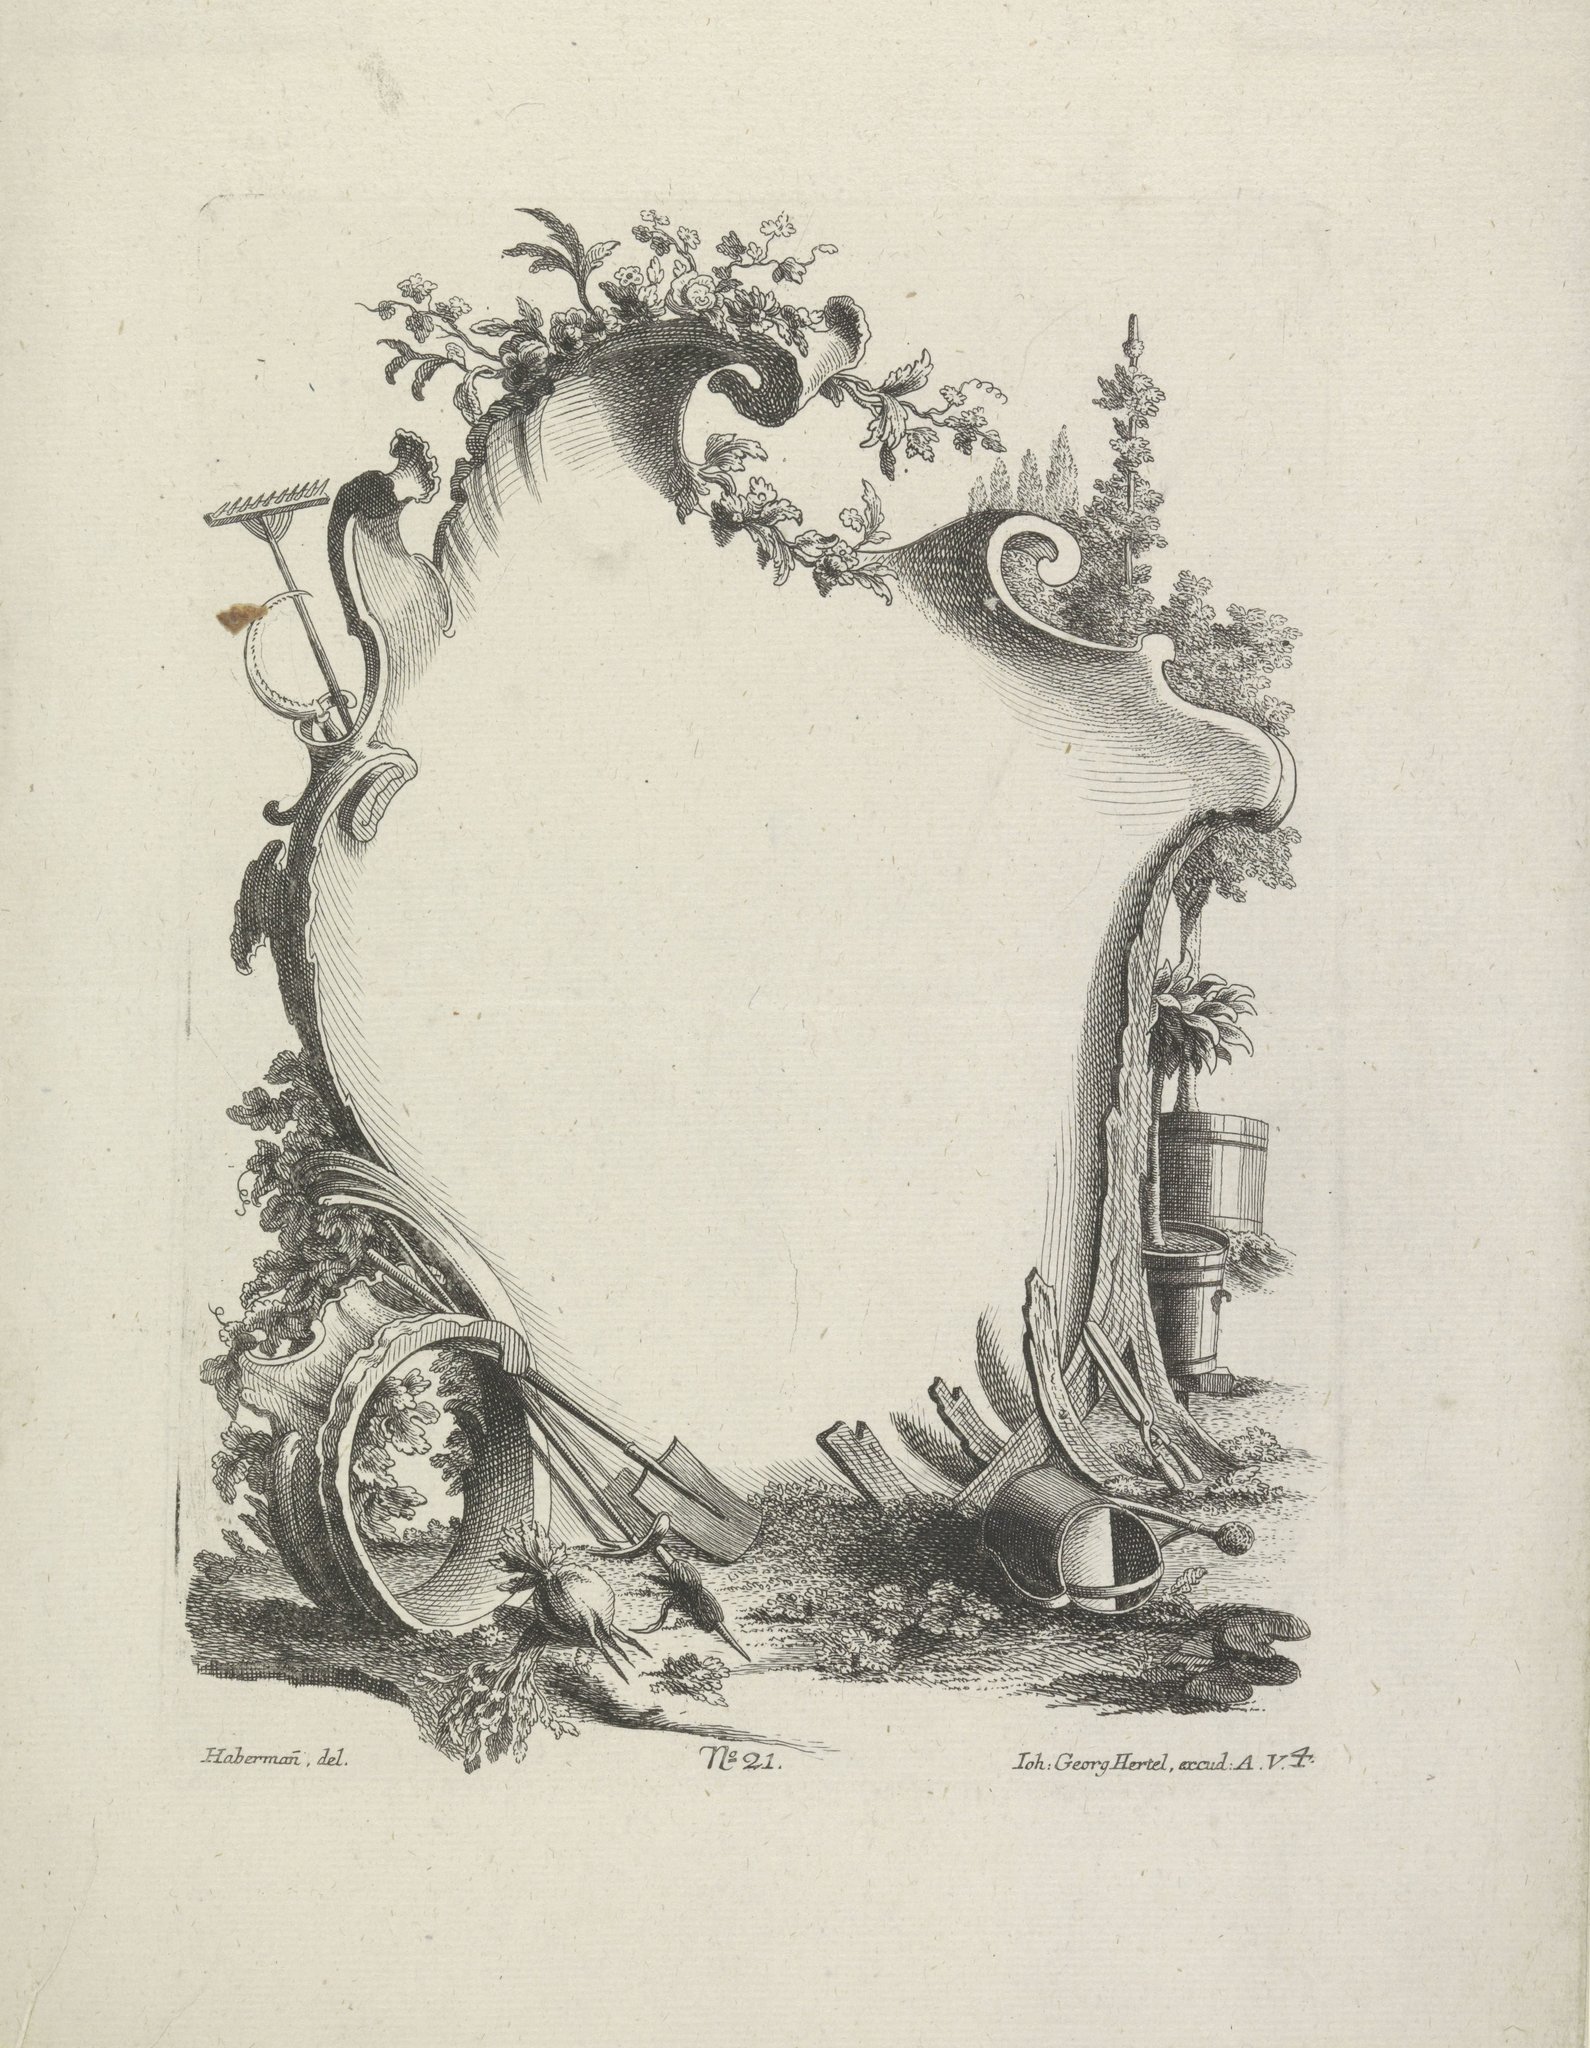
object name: ornament print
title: Cartouche met emblemen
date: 1731-1775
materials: paper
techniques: etching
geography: augsburg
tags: harvest, ornament ~ cartouche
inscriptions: collector's mark: Lugt 2228, collector's mark: Lugt 2760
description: Rocaille cartouche met agrarische objecten zoals een schep, sikkel, hark, gieter en groente. Uitgeversnummer 21.